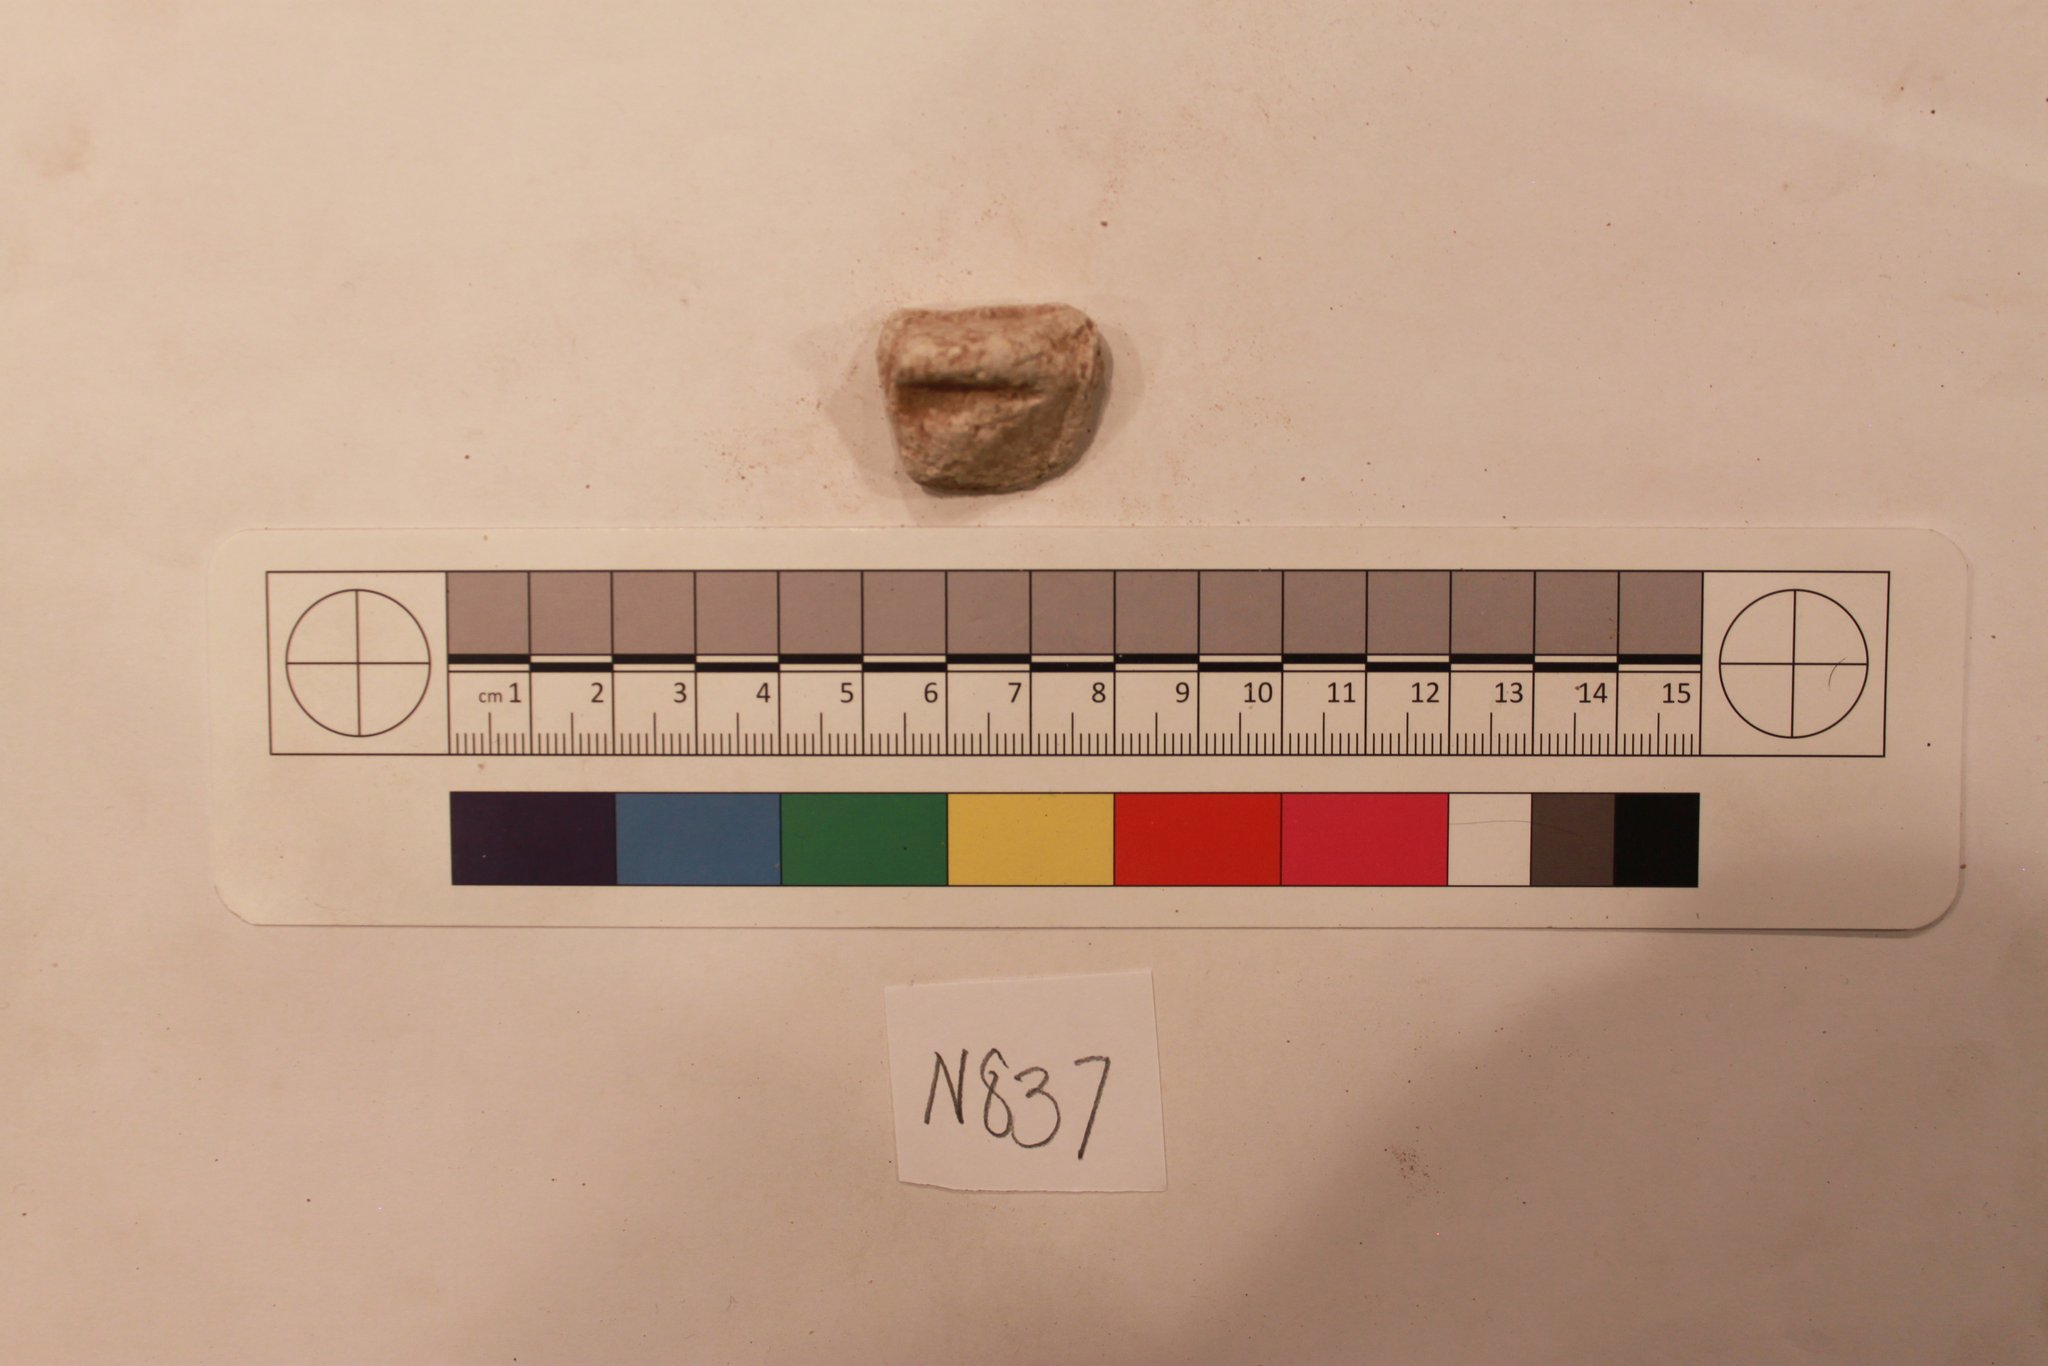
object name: fragment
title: Stucco Fragment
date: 701-1200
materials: plaster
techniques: carving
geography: iran